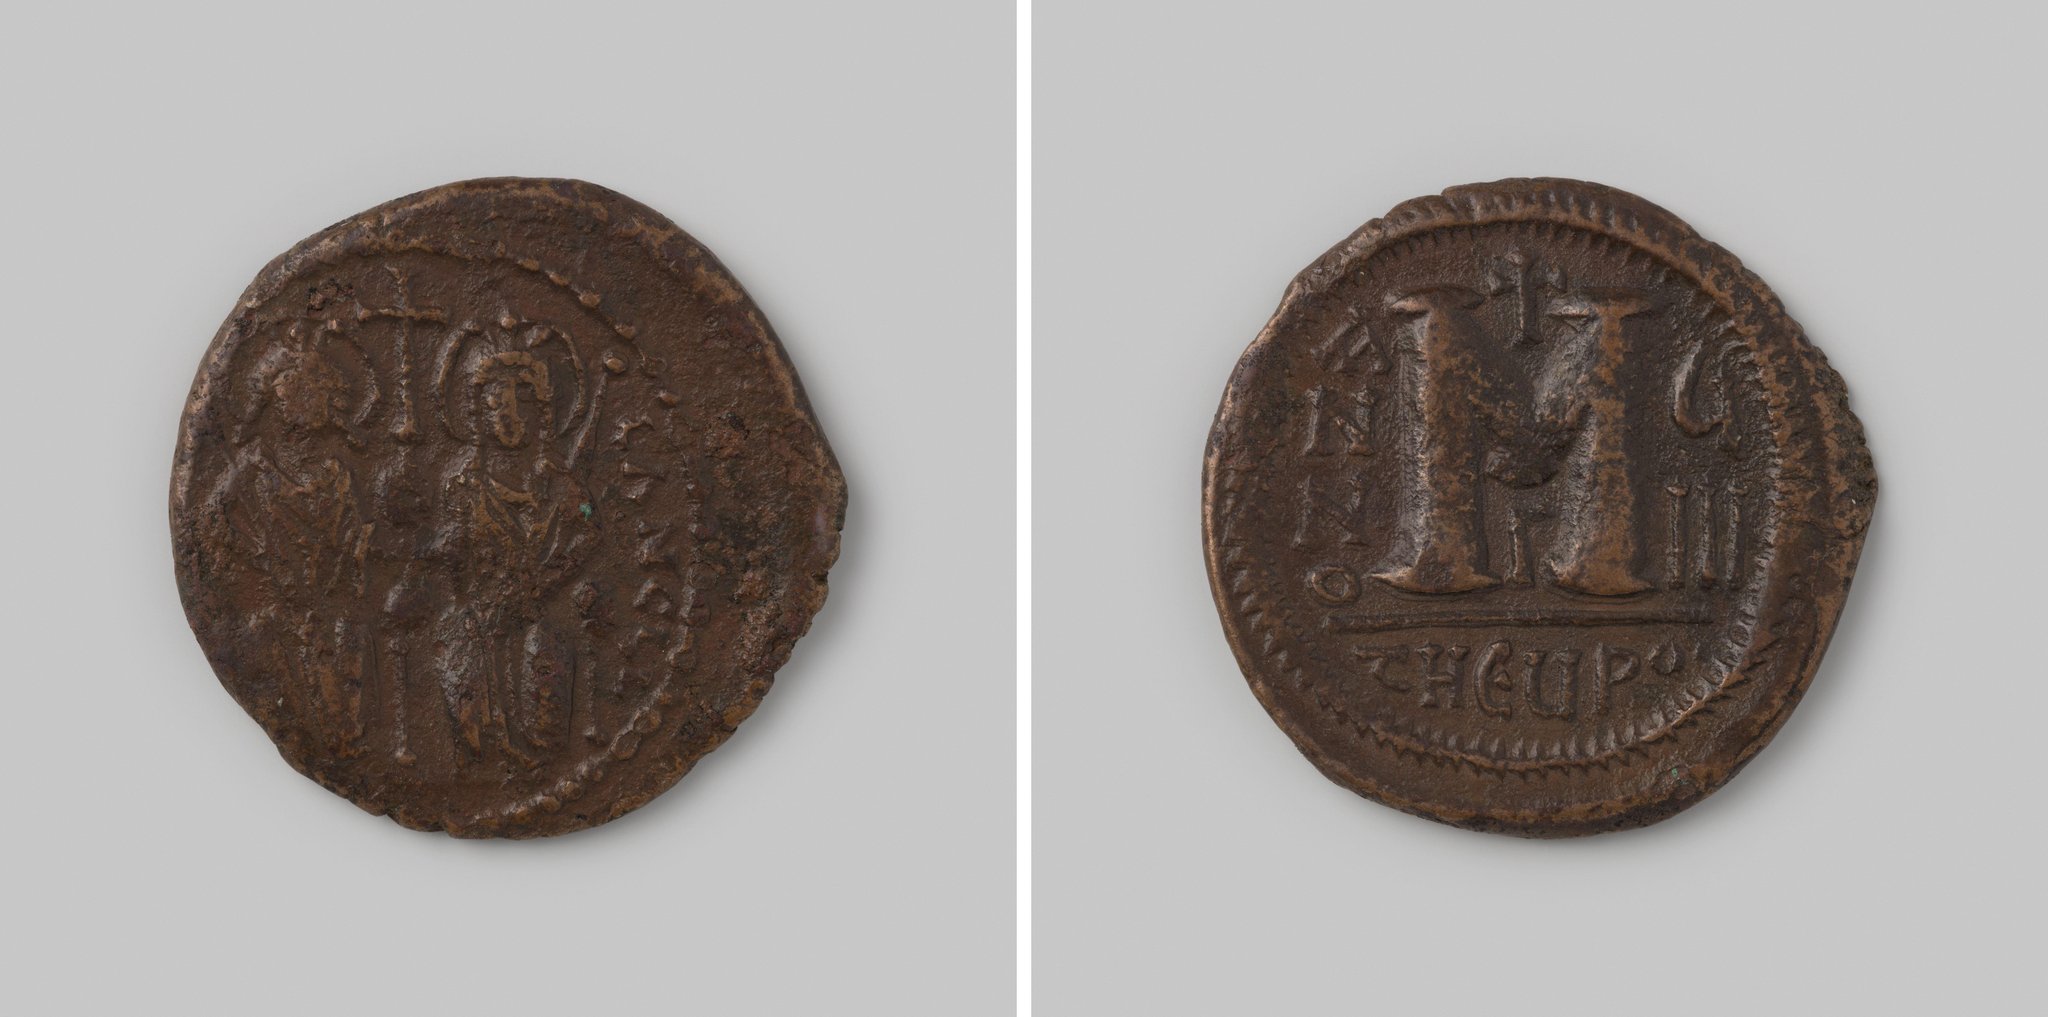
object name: veertig nummia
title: Follis uit het Byzantijnse Keizerrijk van Justinus II en Sofia, 565-578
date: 573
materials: bronze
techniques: striking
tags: aelia sofia, keizer, justinus ii (keizer van het byzantijnse rijk)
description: Bronzen munt. Voorzijde: de keizer en de keizerin zittend met tussen hen hemelbol met kruis. Keerzijde: tussen jaar-aanduiding Anno VIII letter M [=40, waarde-aanduiding, 40 nummia] met boven de letter een kruis. In de afsnede de letters THEUPO [=Theoupolis].